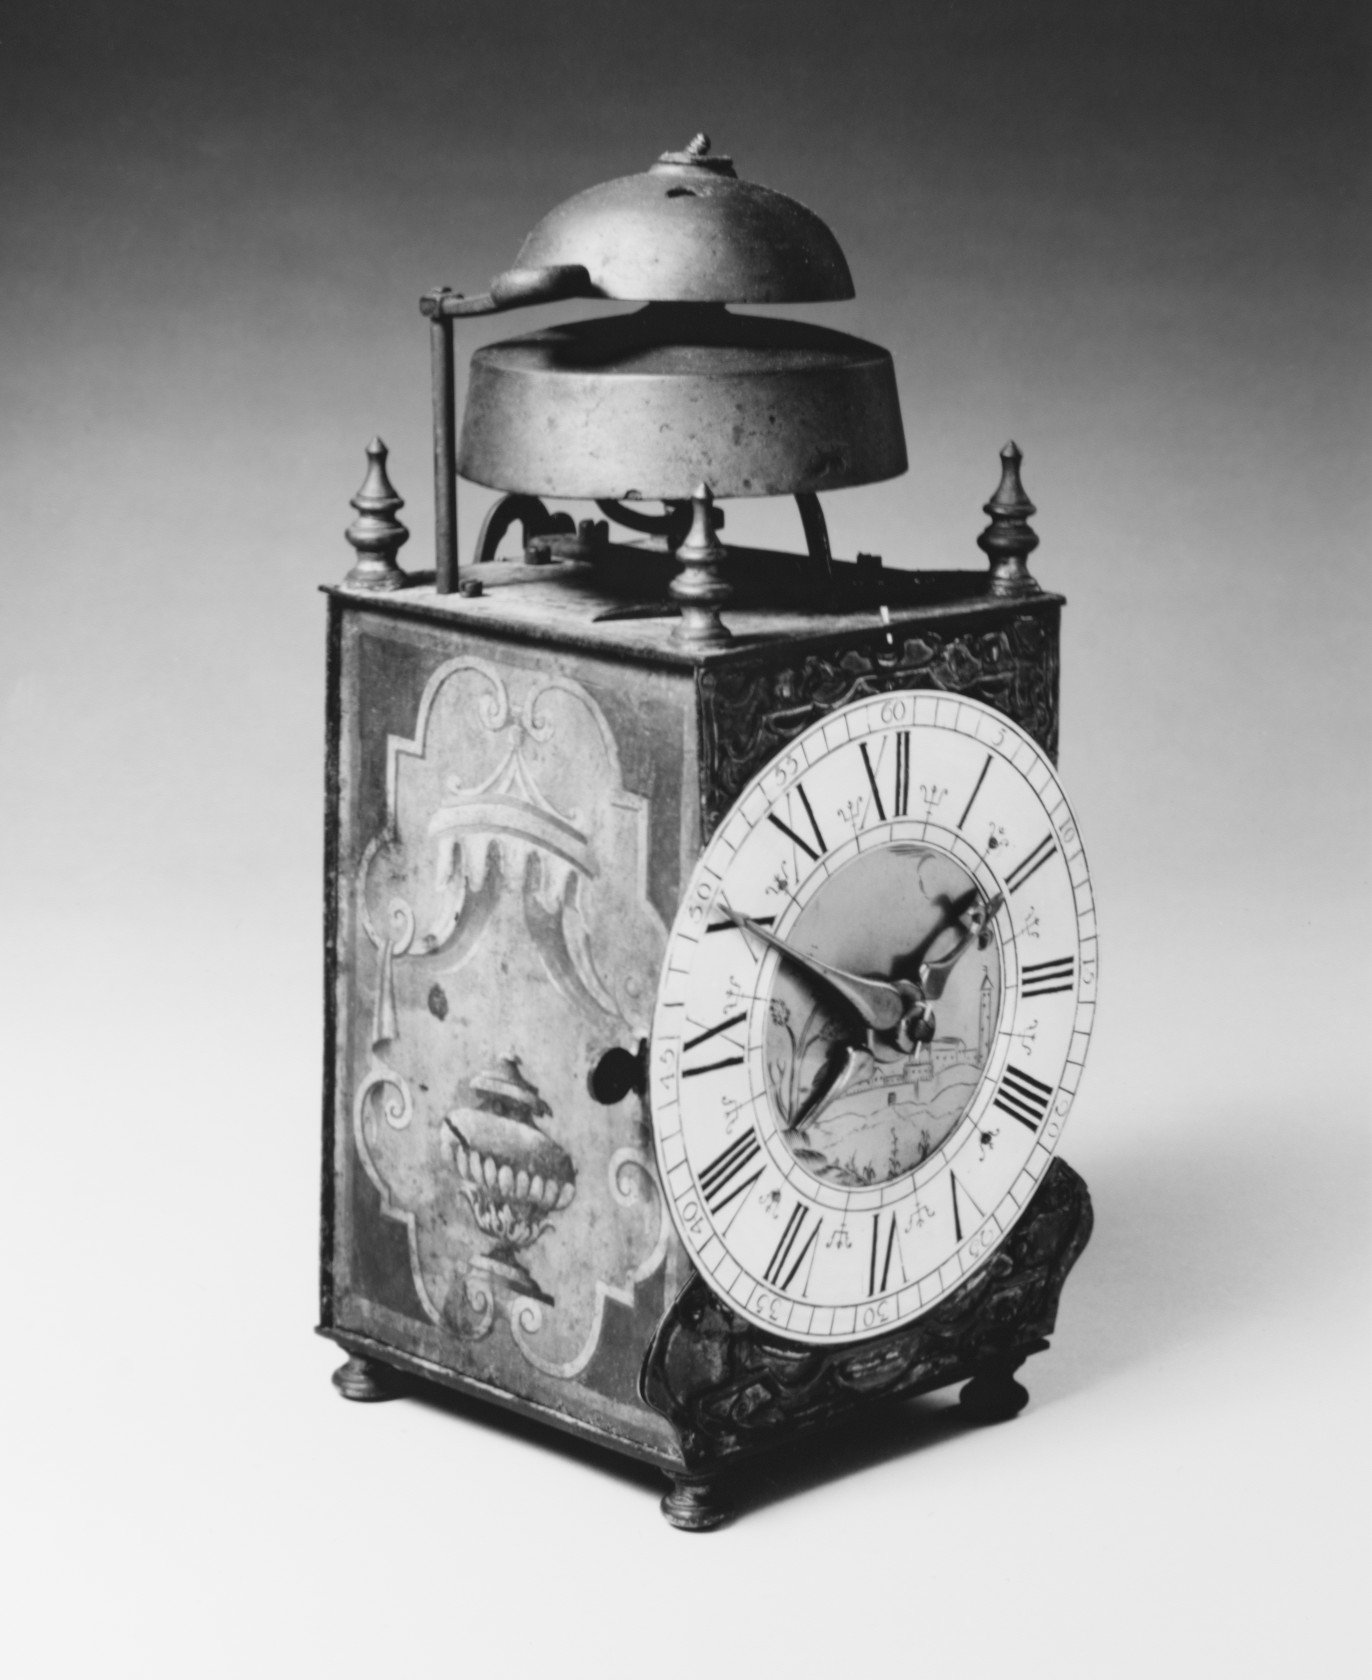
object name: clock movement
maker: filippo polvini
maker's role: maker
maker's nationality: italian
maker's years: 1745-1748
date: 1745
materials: brass, iron